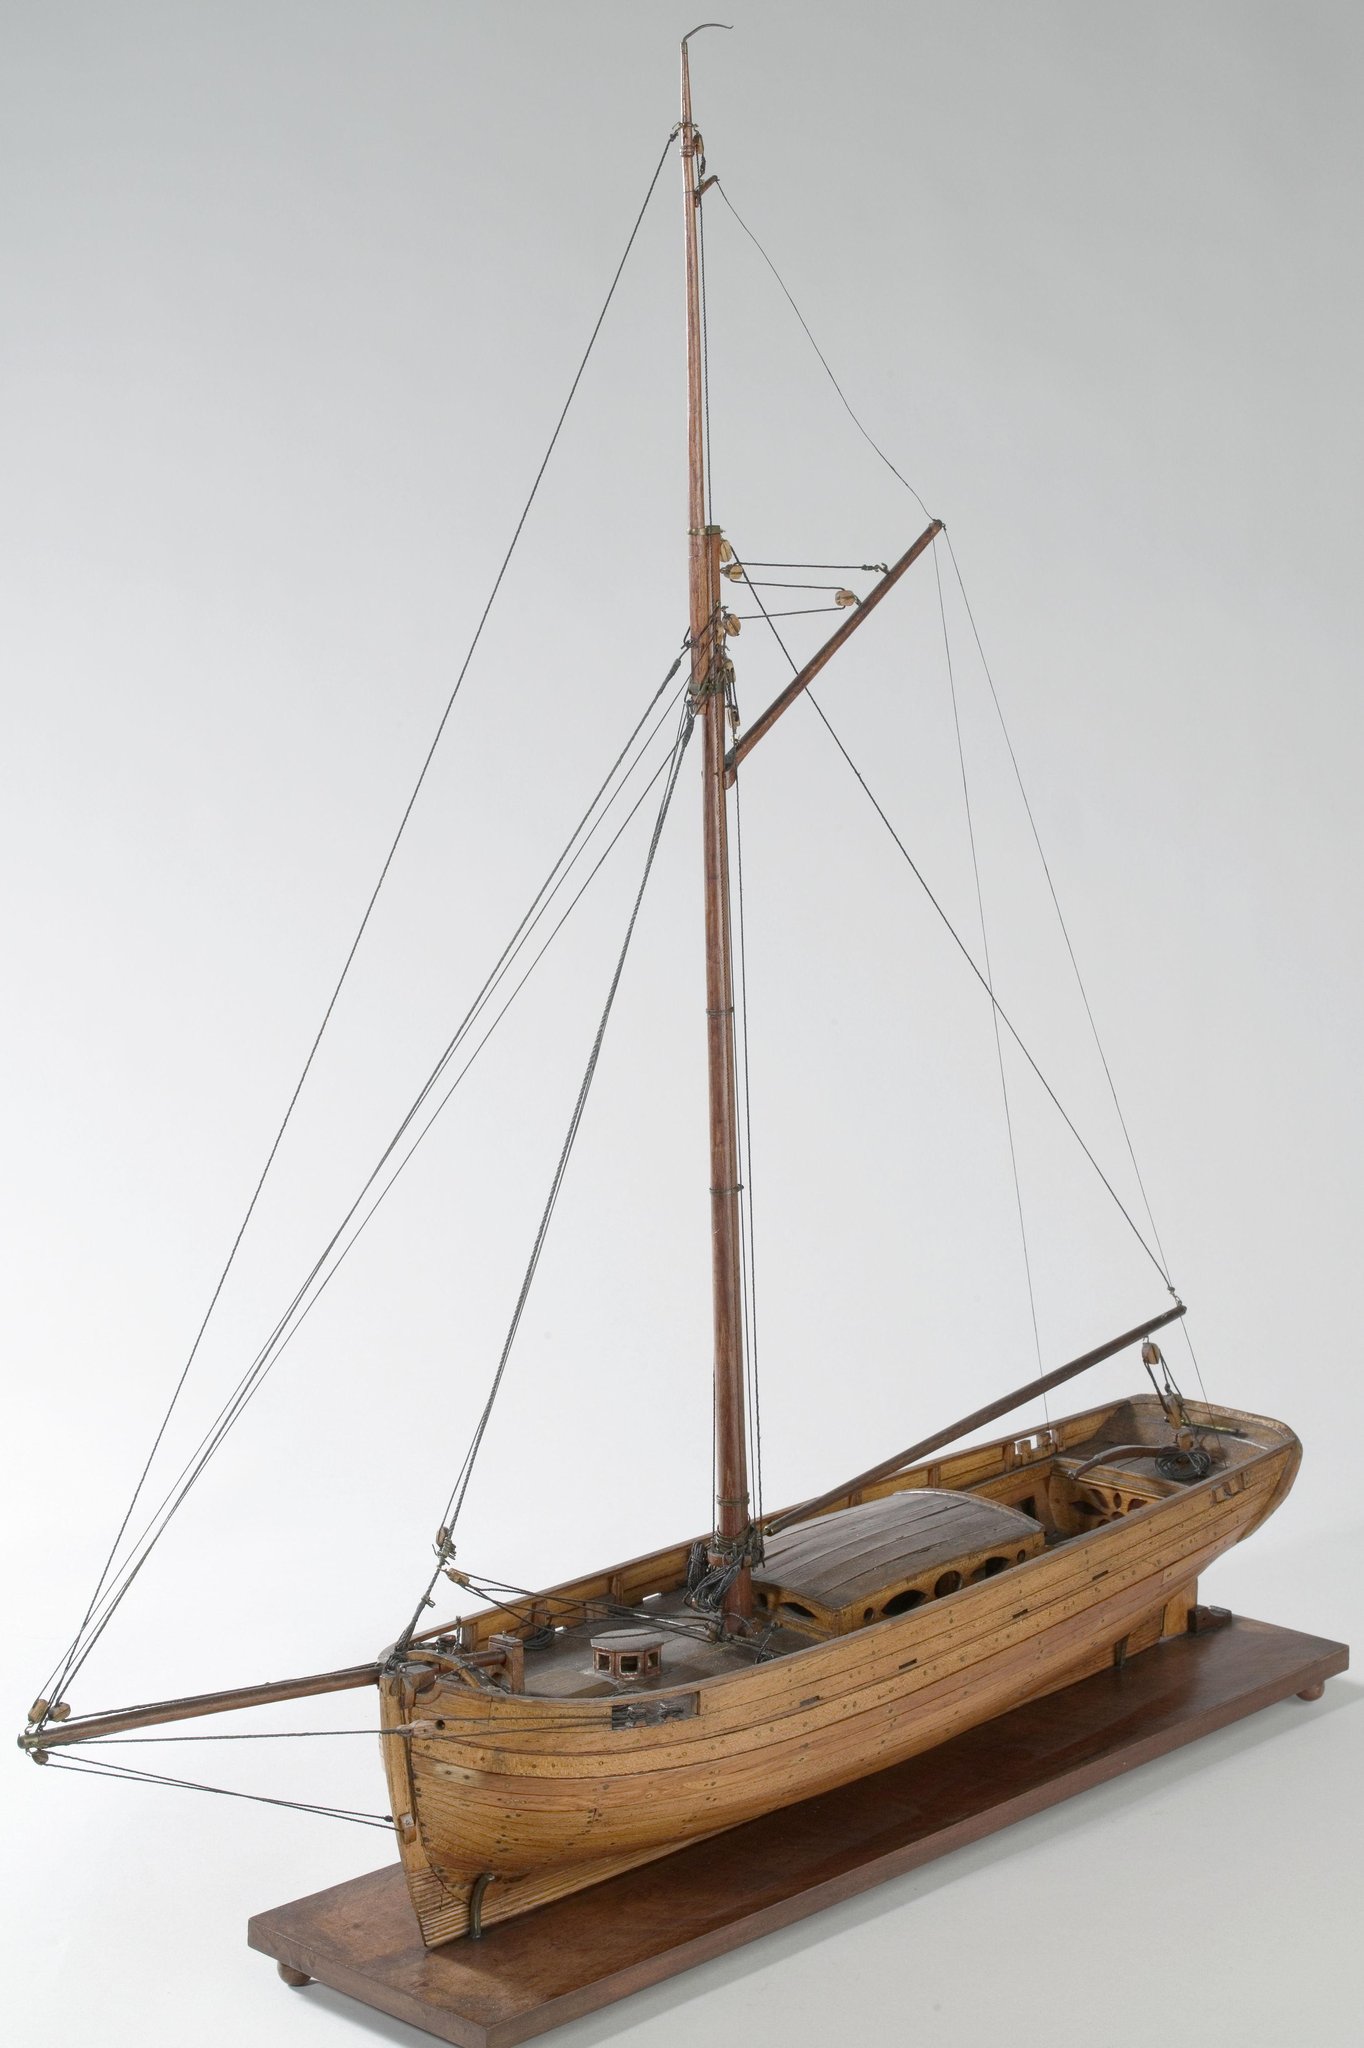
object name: fully rigged model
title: Model of a Gentleman's Yacht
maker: Anonymous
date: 1828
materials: brass, iron, fiber, wood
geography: harlingen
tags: zoe (scheepsnaam)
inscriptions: inscription, on the taffrail: ‘ZOE’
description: Getuigd spantmodel zonder zeilen van een sloep, op grondplank. Het is een enkelmast jacht met kottersteven, gewrongen spiegel, plat wulf en plat hek. Het model heeft een dek, kuip, kajuit en vooronder. Het brede roer met gebogen helmstok is door middel van een staaf door vingerlingen aan roer en steven bevestigd. De zeeg is nagenoeg vlak, het model heeft een barkhout. De gladboordige romp is een gepiekt rondspant met hoge kiel, die in de lengterichting gegroefd is. Het model is getuigd met een ovale mast met steng, gaffel en giek, en een boegspriet; op het dek een overloop. Resten van textiel in het ruim doen vermoeden dat het oorspronkelijk wel van zeilen voorzien is geweest.